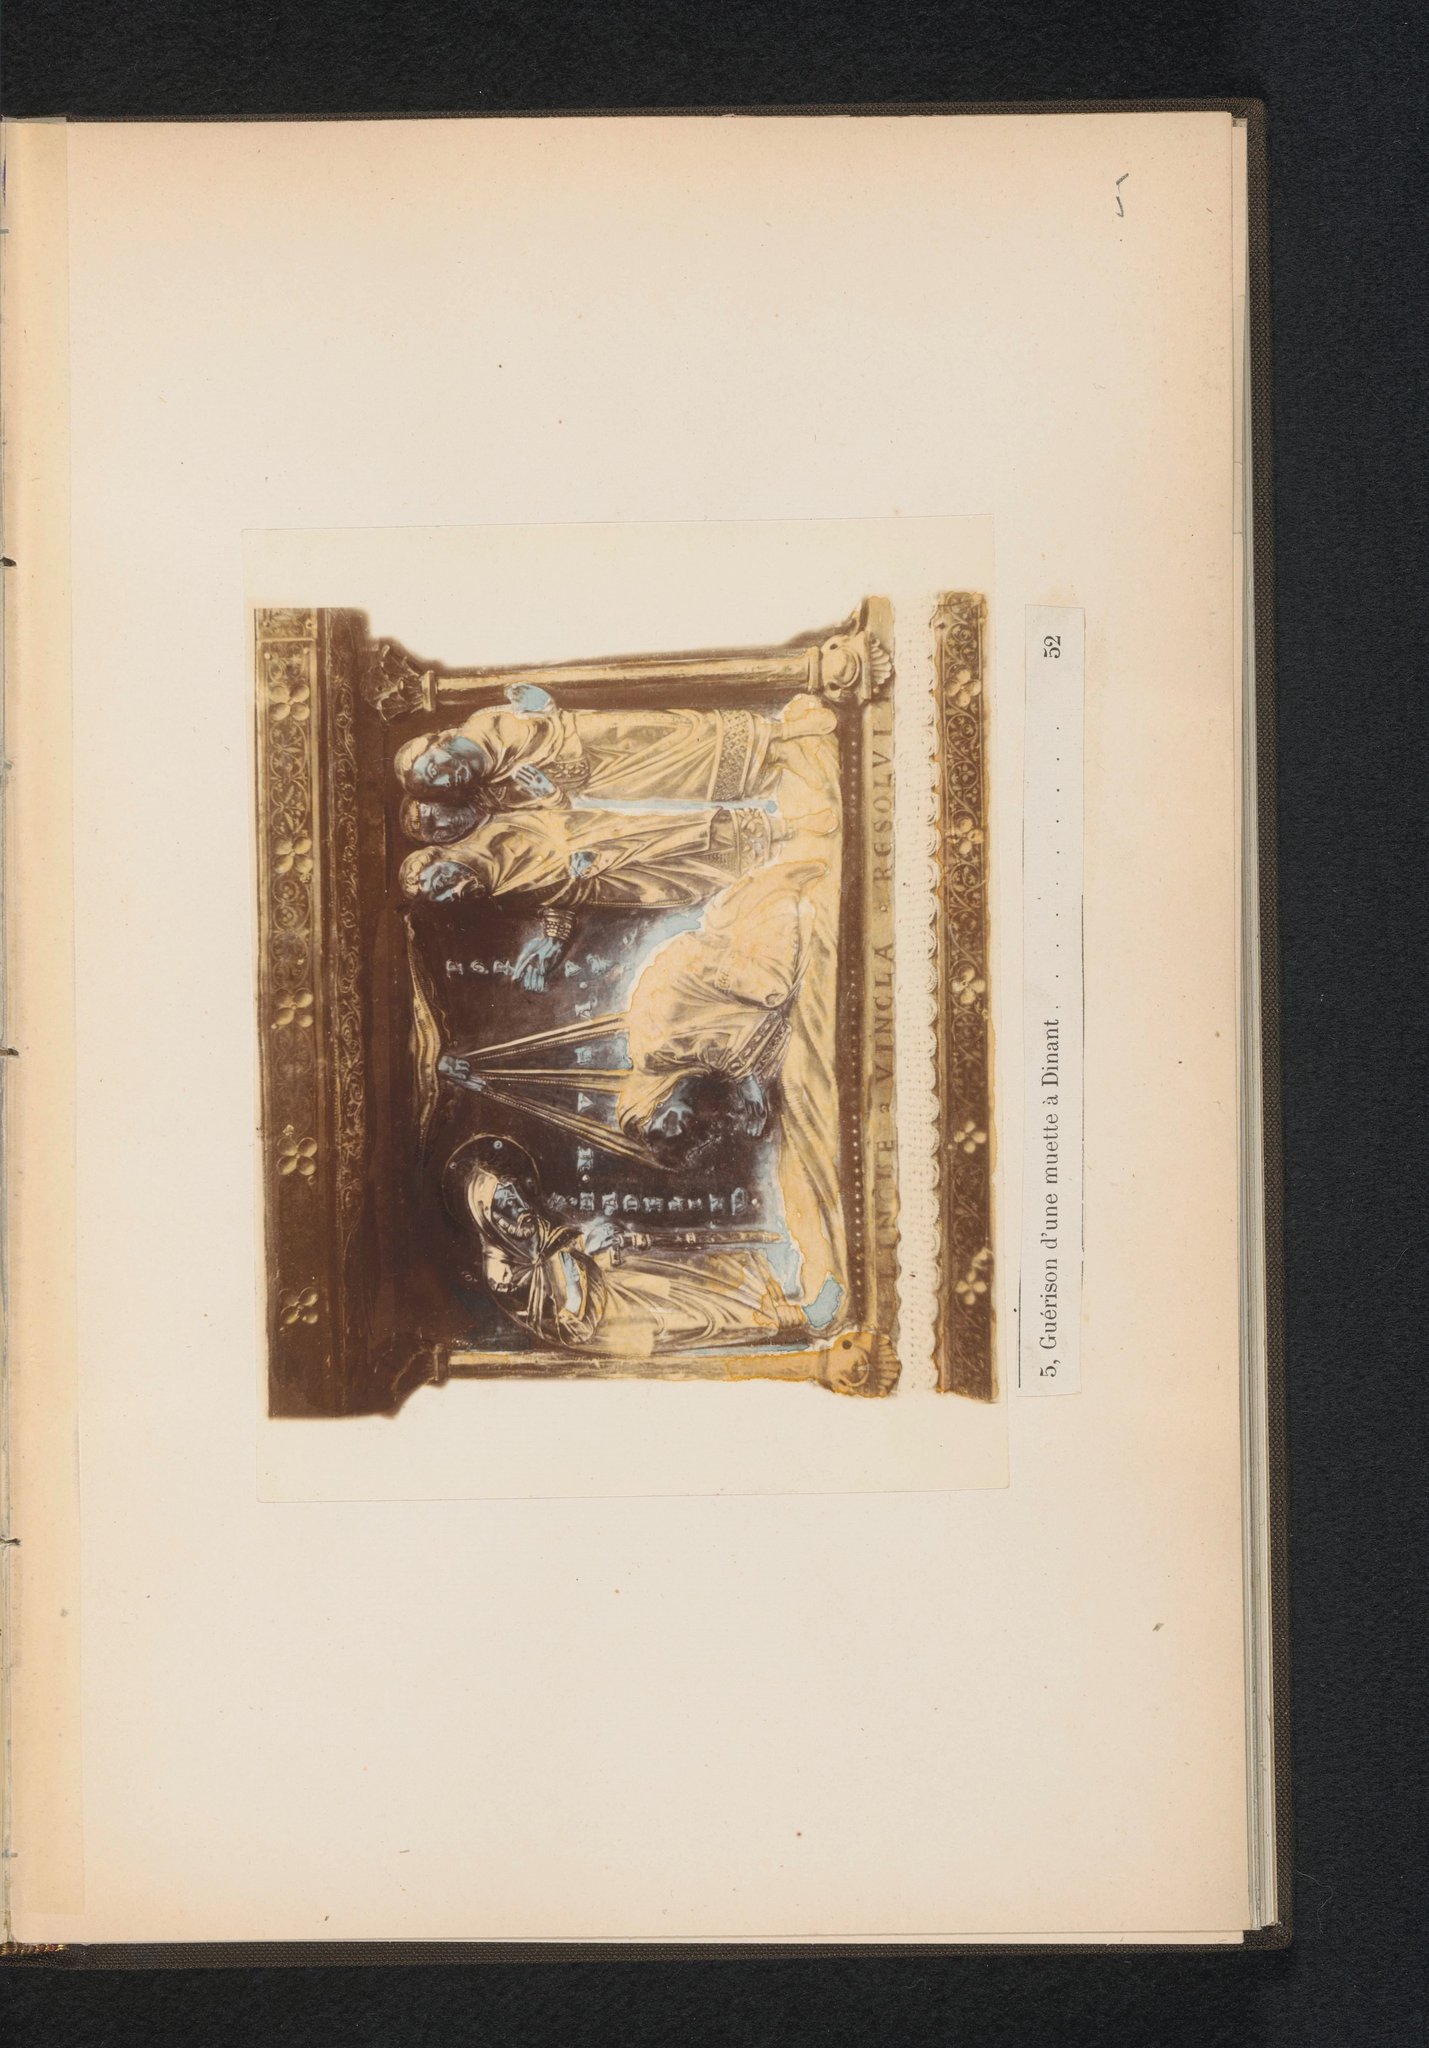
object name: page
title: Reliëf van de genezing van een dove vrouw die niet kon spreken in Dinant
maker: Anonymous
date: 1877-1882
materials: photographic support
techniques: albumen print, hand coloring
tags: deaf and non-verbal, formerly known as 'deaf-mute', deaf, deafness, relics (and reliquaries), sculpture (+ relief ~ sculpture)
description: Foto op derde ongenummerde pagina na pagina 52.